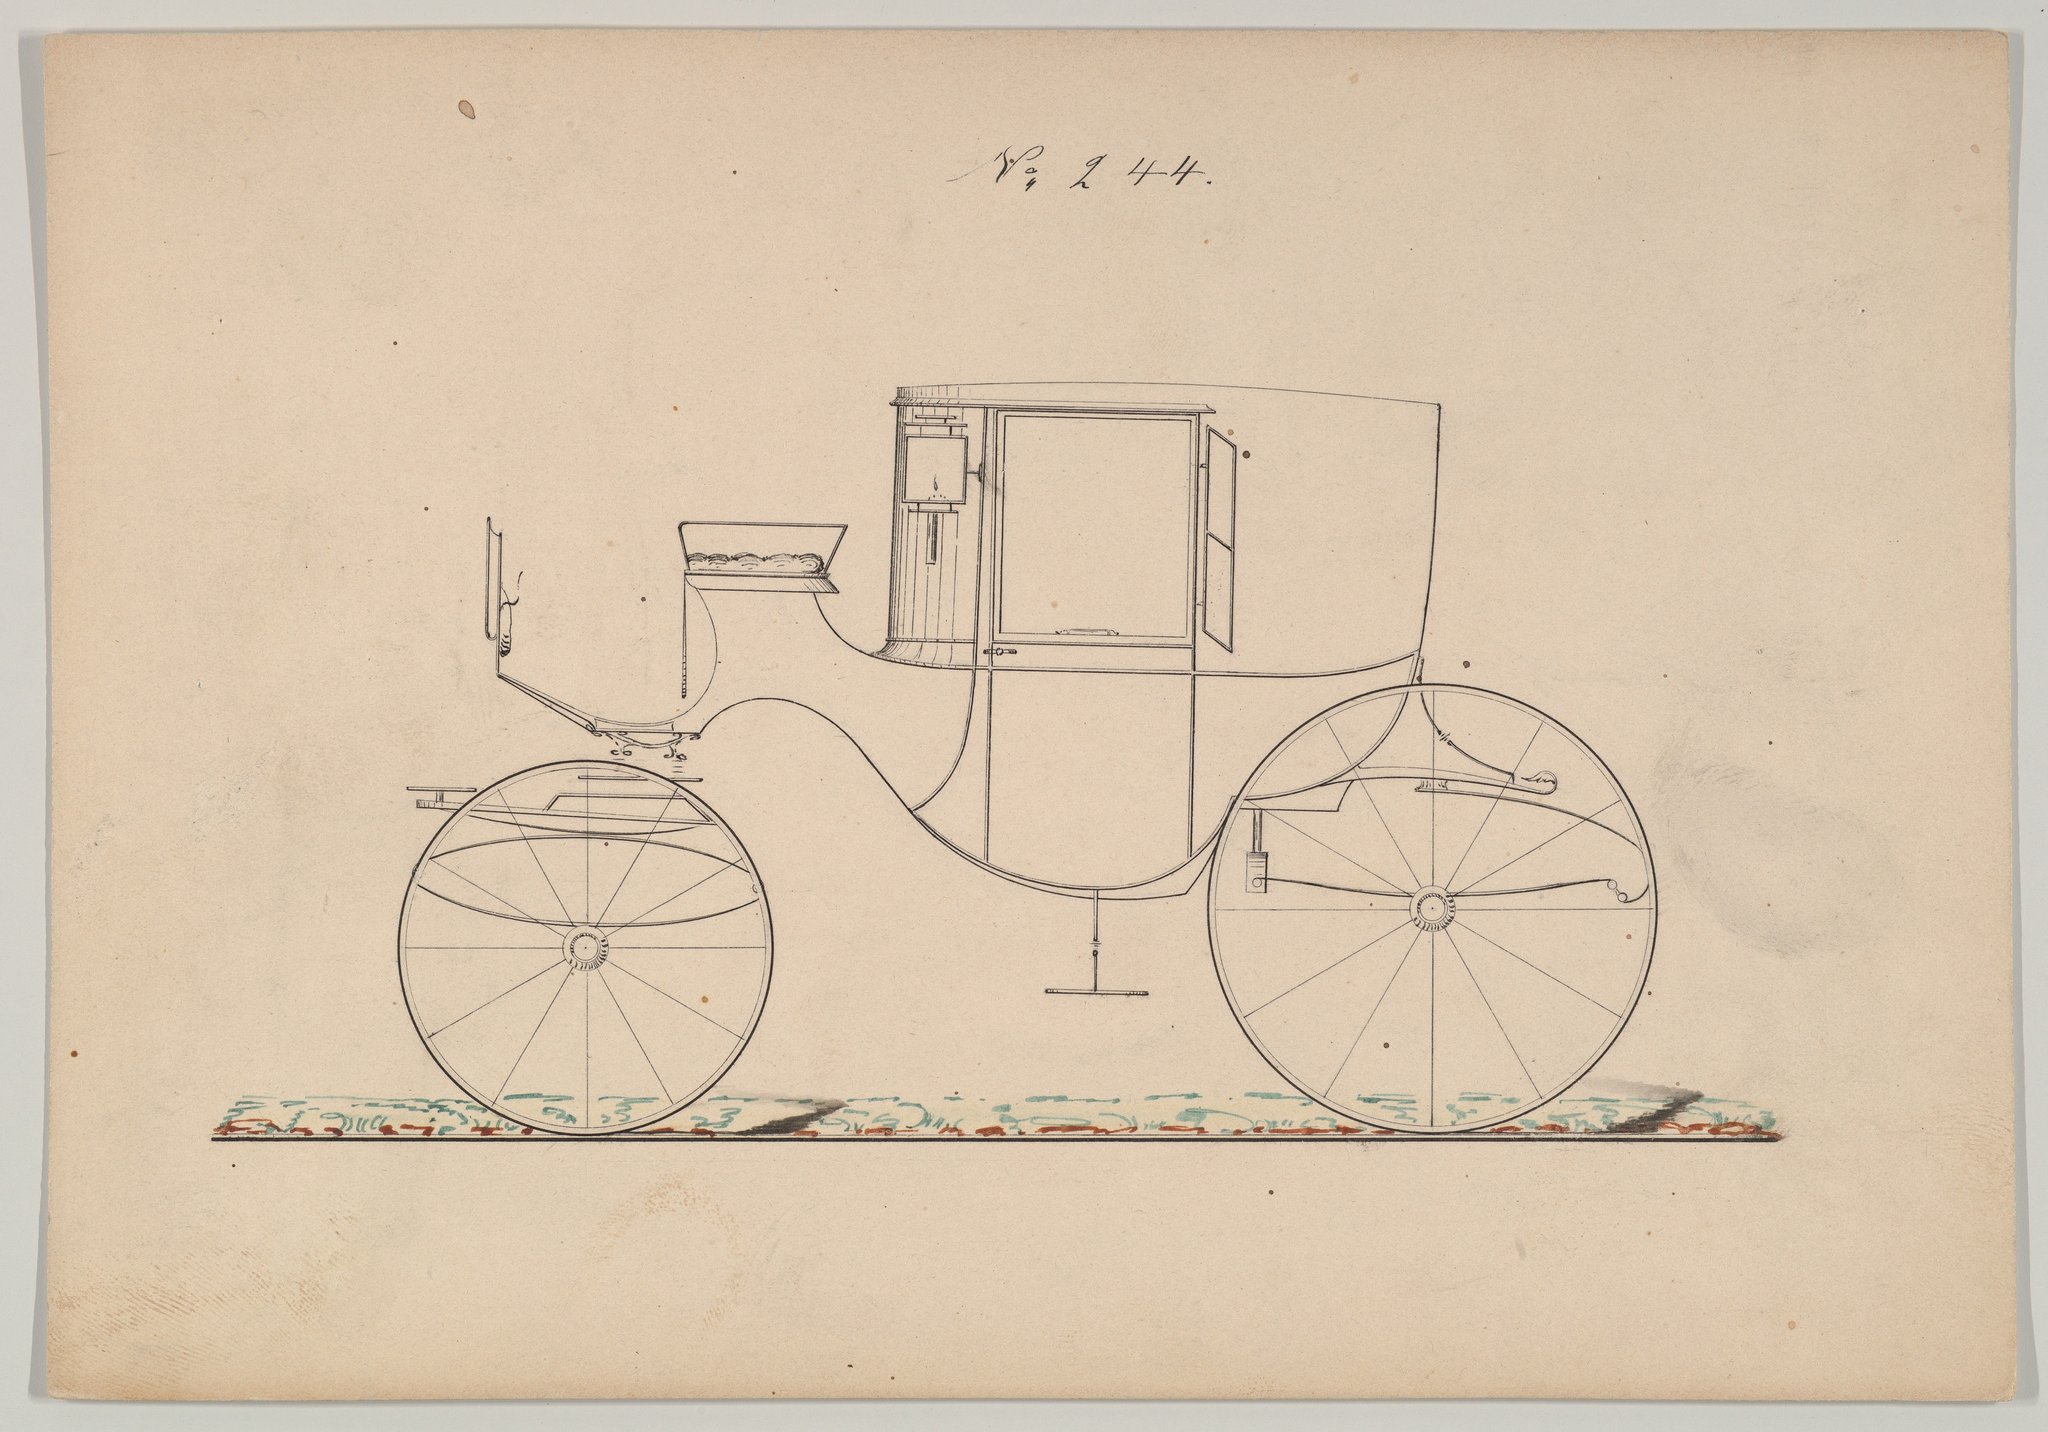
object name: drawing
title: Clarence #244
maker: brewster & co.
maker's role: manufacturer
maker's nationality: american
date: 1850-1870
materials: ink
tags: carriages